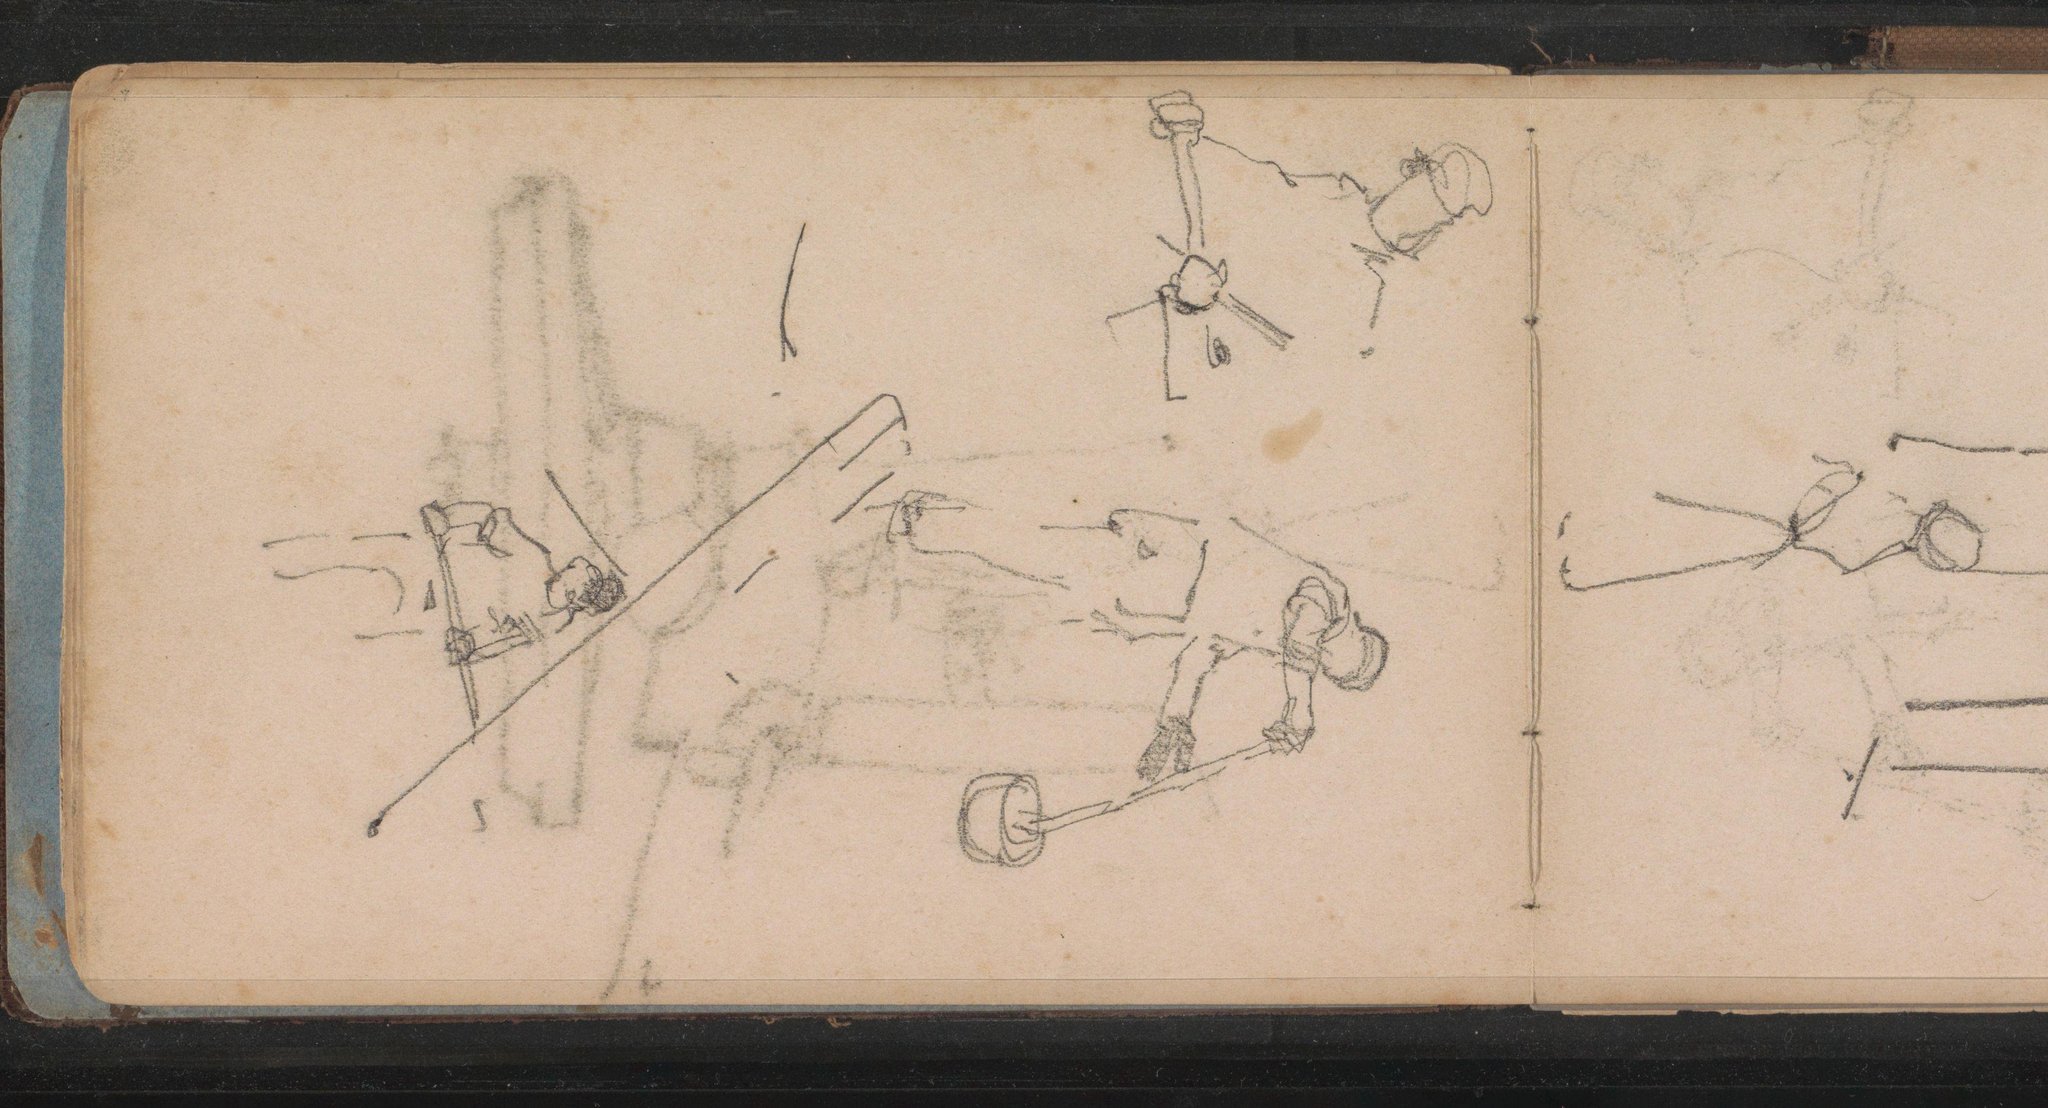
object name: sketchbook leaf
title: Werkende mannen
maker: george hendrik breitner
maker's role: draughtsman, painter, print maker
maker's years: 1857-1923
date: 1880-1882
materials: chalk, paper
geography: scheveningen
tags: working class, labourers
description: Ze teren mogelijk schepen. Pagina 17 uit een schetsboek met 37 bladen.